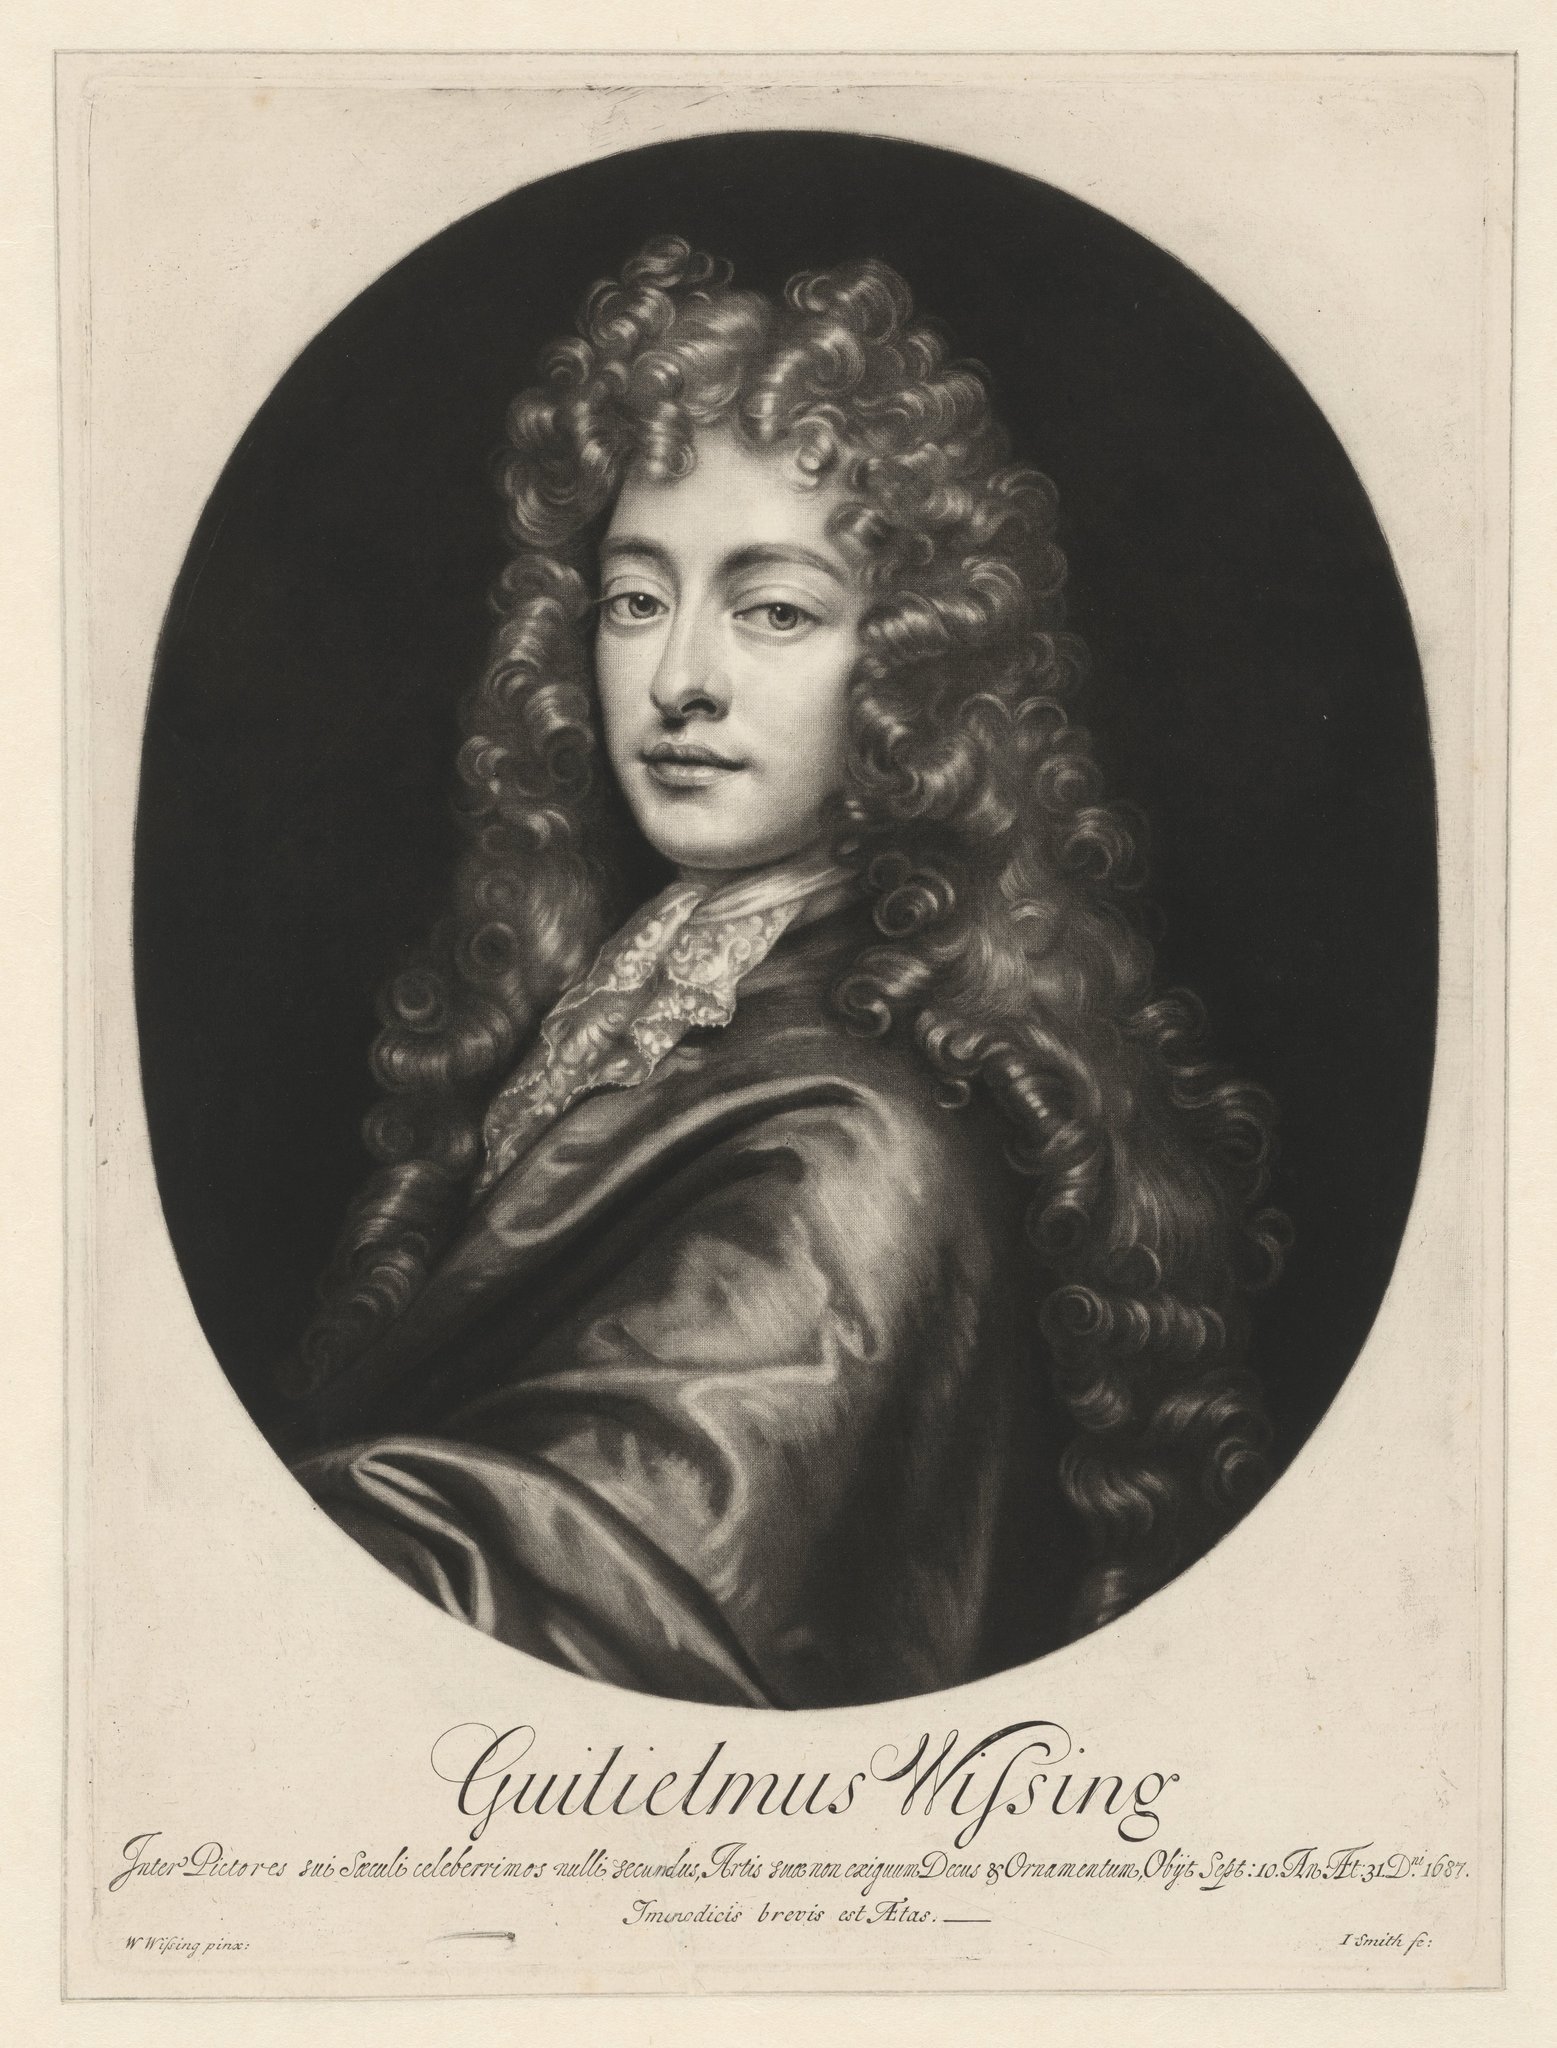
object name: print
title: Portret van Willem Wissing op 31-jarige leeftijd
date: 1687-1742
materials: paper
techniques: mezzotint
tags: amsterdam, painter, willem wissing, historical persons, portrait, self-portrait of painter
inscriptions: collector's mark: Lugt 2228, collector's mark: Lugt 2760